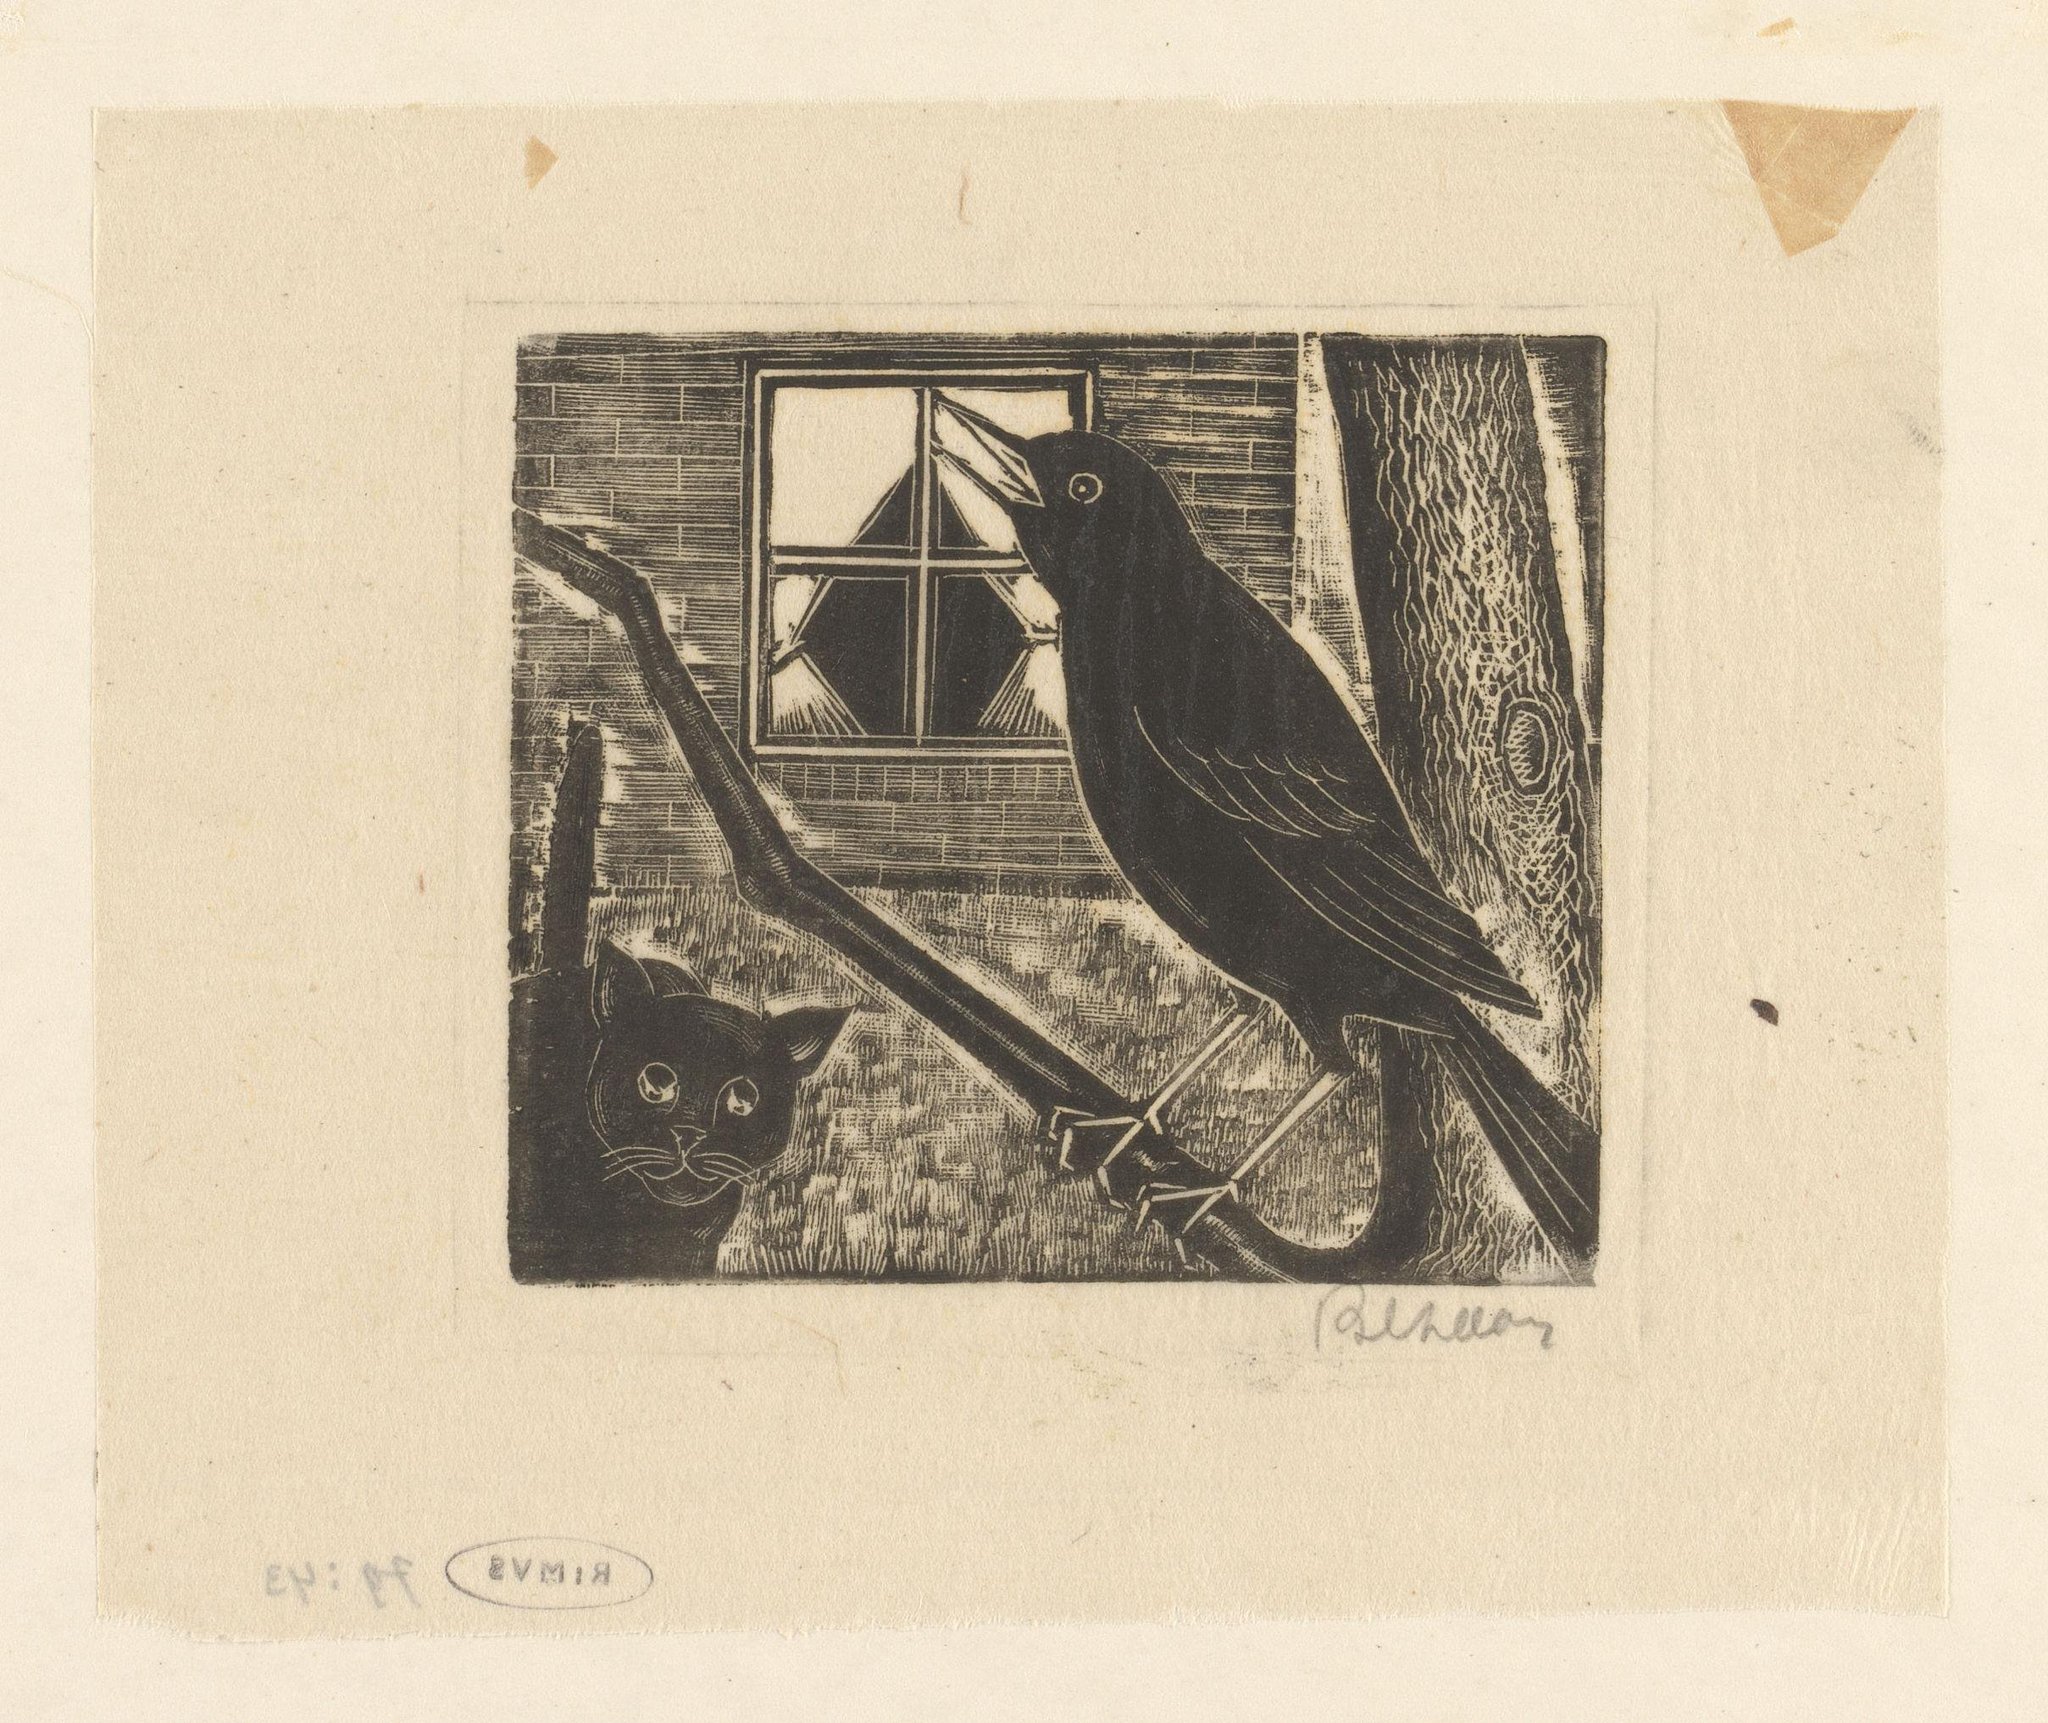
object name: print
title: Mijn lijster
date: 1941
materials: paper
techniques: engraving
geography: putten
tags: cat, song-birds: blackbird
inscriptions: collector's mark: Lugt 2228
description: Prent gebruikt voor: Hattum, Jac. van. Van Odrimond, Millimas en anderen. Putten: D.J. Terwee, [1941].